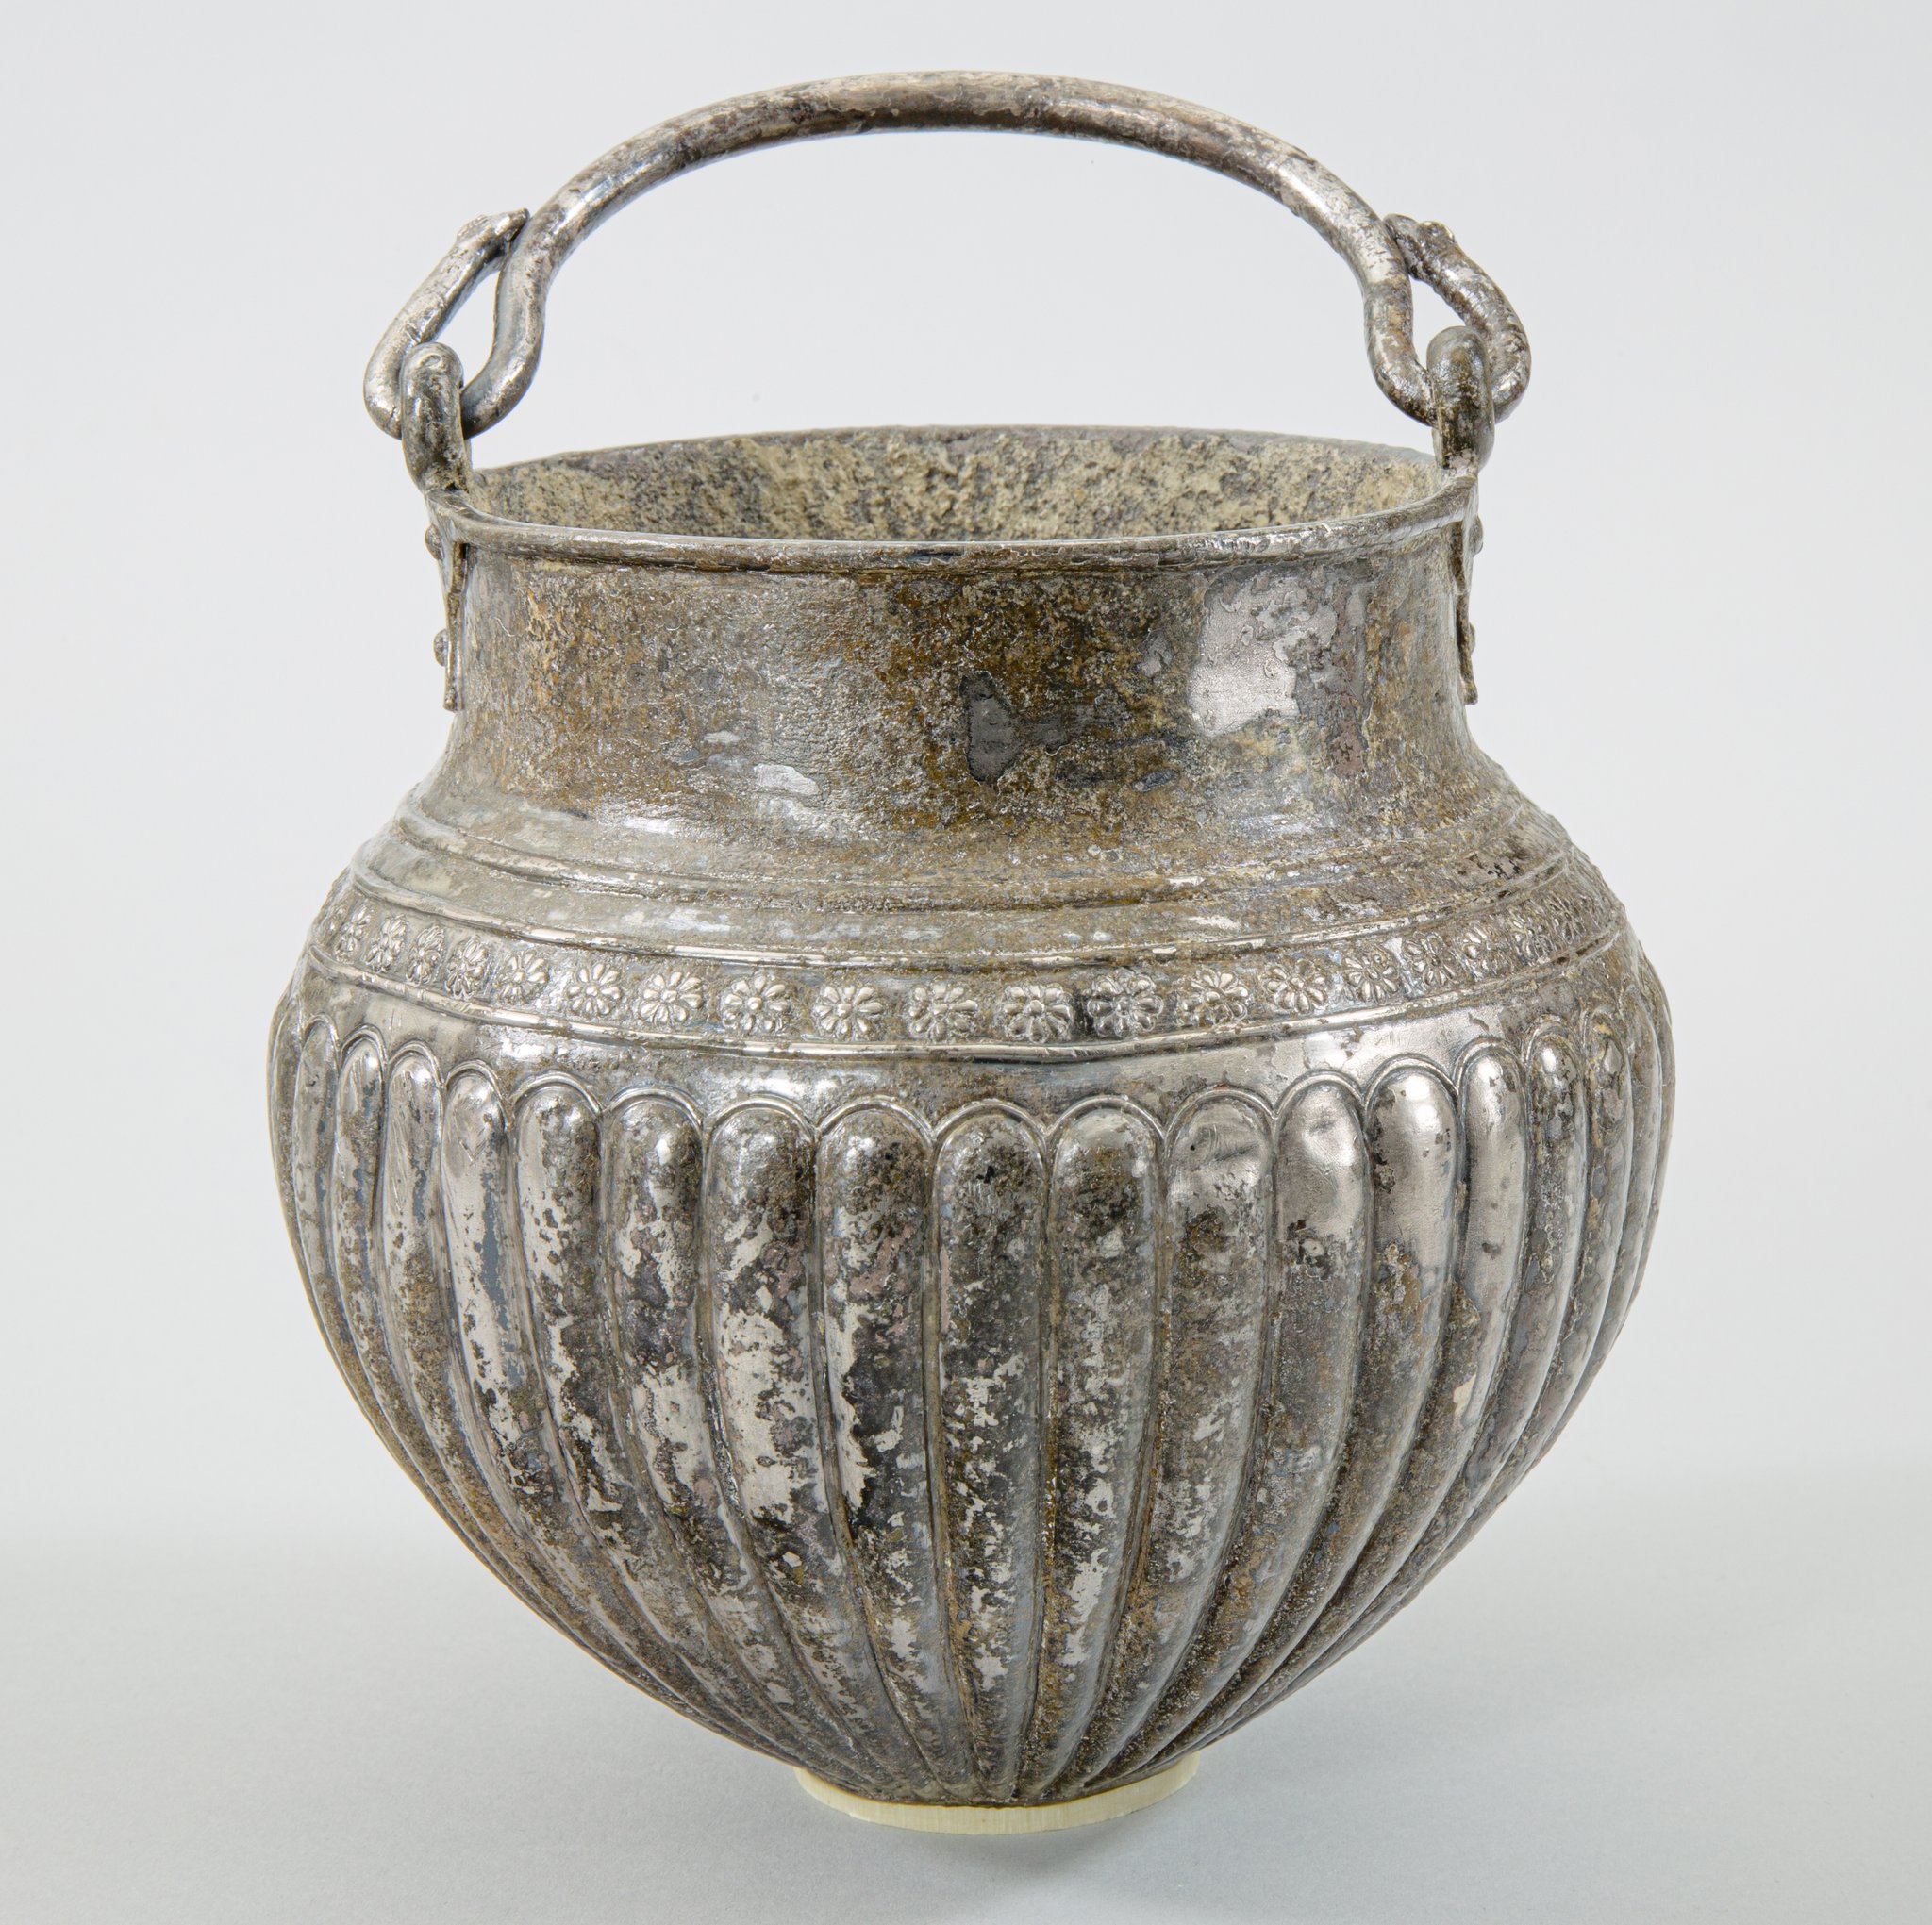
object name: situla with swinging handle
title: Silver situla (pail) with swinging handles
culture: east greek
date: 600-501 BCE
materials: silver